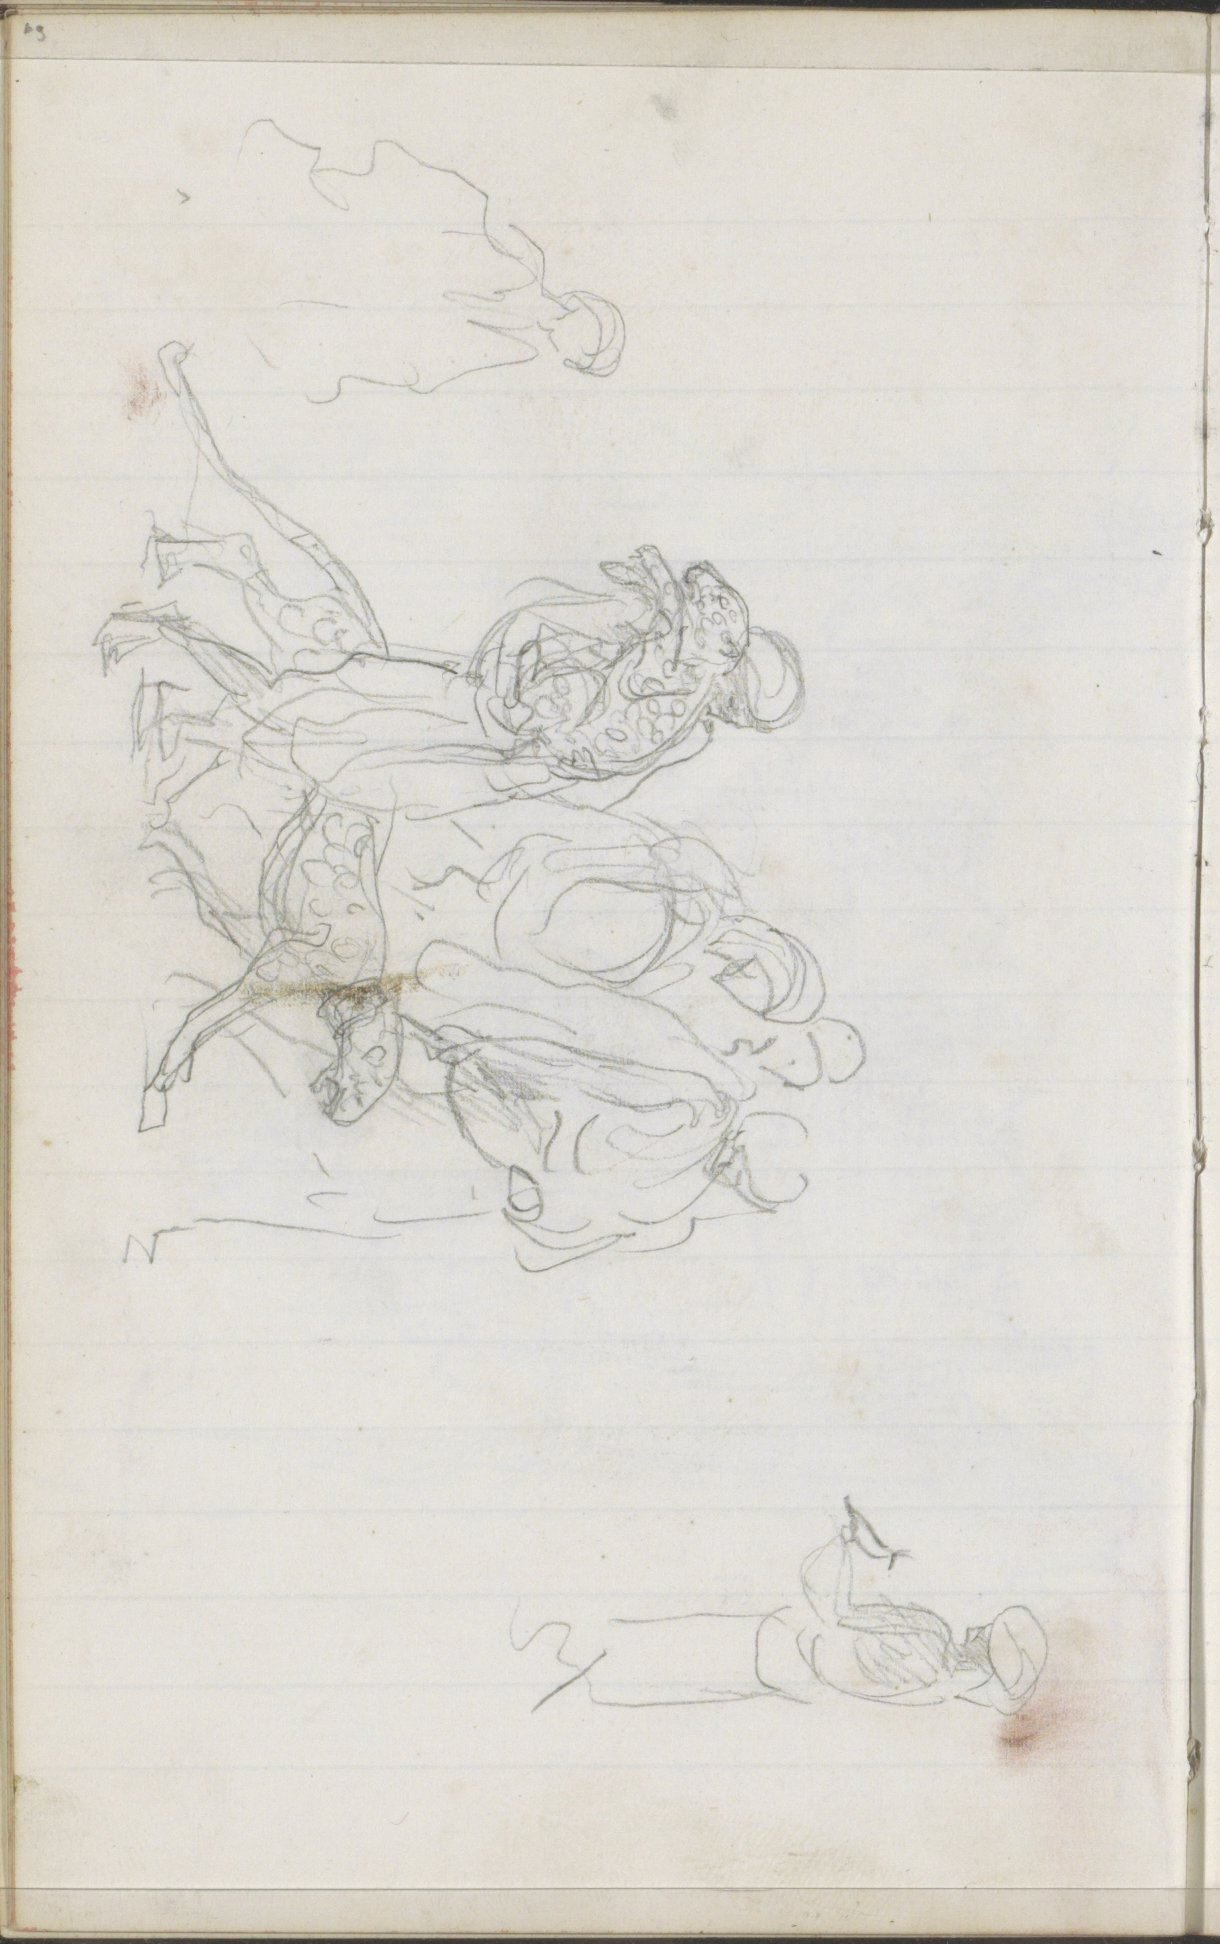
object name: sketchbook leaf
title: Indiërs met luipaarden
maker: marius bauer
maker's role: draughtsman, print maker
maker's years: 1867-1932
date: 1897-1898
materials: pencil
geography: india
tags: standing figure, beasts of prey, predatory animals: leopard, birds, walking, asiatic races and peoples: indians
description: De figuren lopen met een luipaard aan een ketting. Een andere figuur draagt een kleine luipaard over de schouder. Tevens een studie van een man met een vogel op de hand. Pagina 69 uit een schetsboek met 62 bladen.